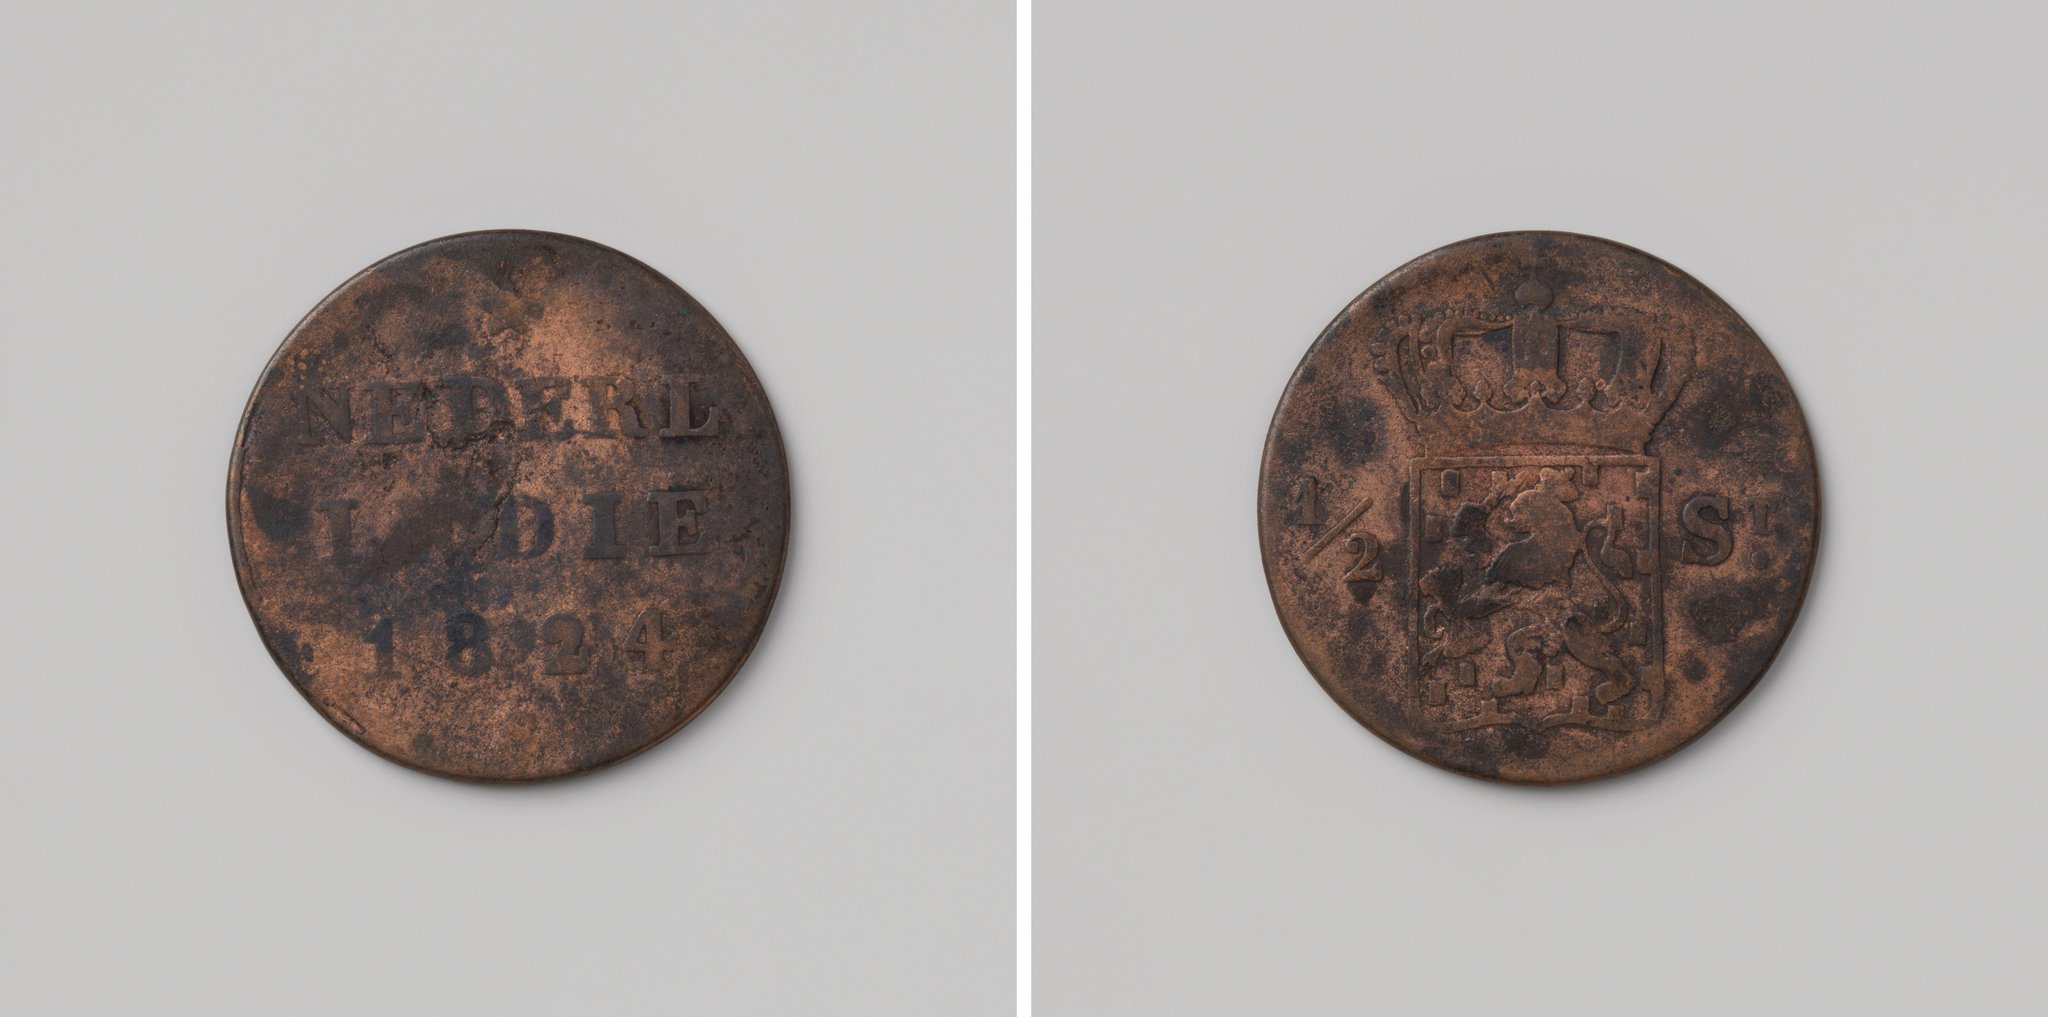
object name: coin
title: 1/2 VOC-stuiver van koper uit 1824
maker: Anonymous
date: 1824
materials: copper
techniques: striking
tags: dutch east indies, the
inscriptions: inscription: ‘1/2 St’, inscription: ‘Jacques Schulman / Numismaat / Keizersgracht 448 / Amsterdam-C.’, inscription: ‘NEDERL / INDIE / 1824’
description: Koperen 1/2 stuiver van de VOC uit Nederlands-Indië uit 1824. Voorzijde: opschrift. Keerzijde: een gekroond wapen met leeuw erin; links ervan staat 1/2, rechts ervan staat de letters S. Het muntje zit in een vierkant envelopje met opschrift.